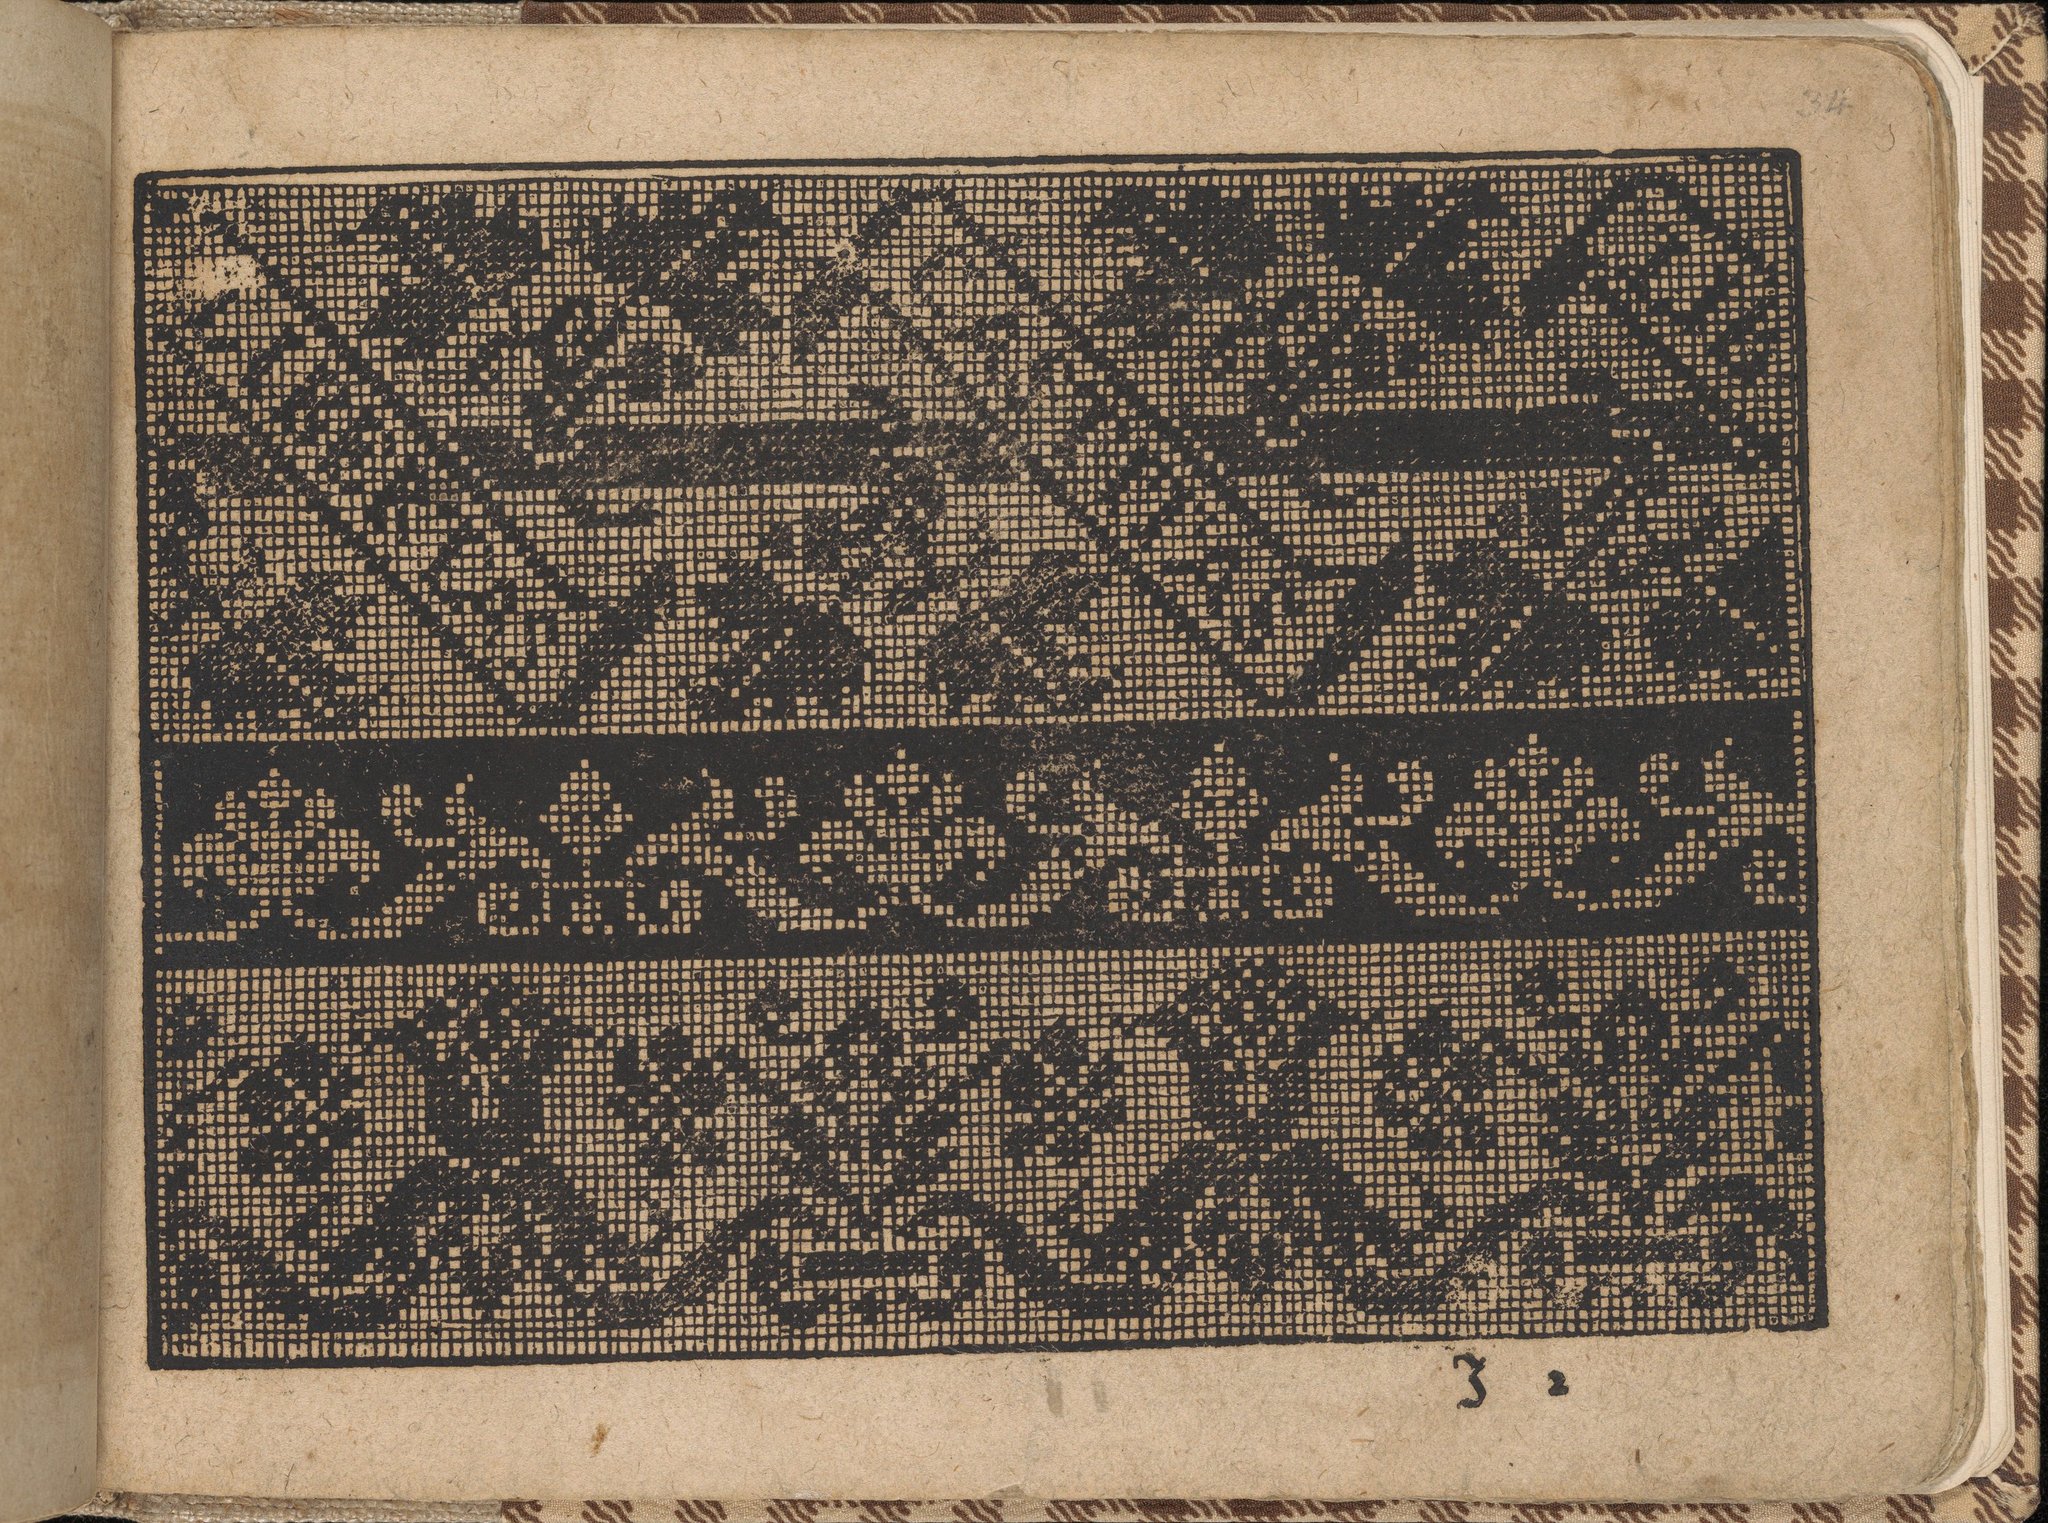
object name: book print ornament architecture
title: New Künstlichs Modelbuch (Page 34 recto)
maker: bernhard jobin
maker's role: publisher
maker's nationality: swiss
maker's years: 1535-1597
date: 1600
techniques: woodcut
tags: ornament